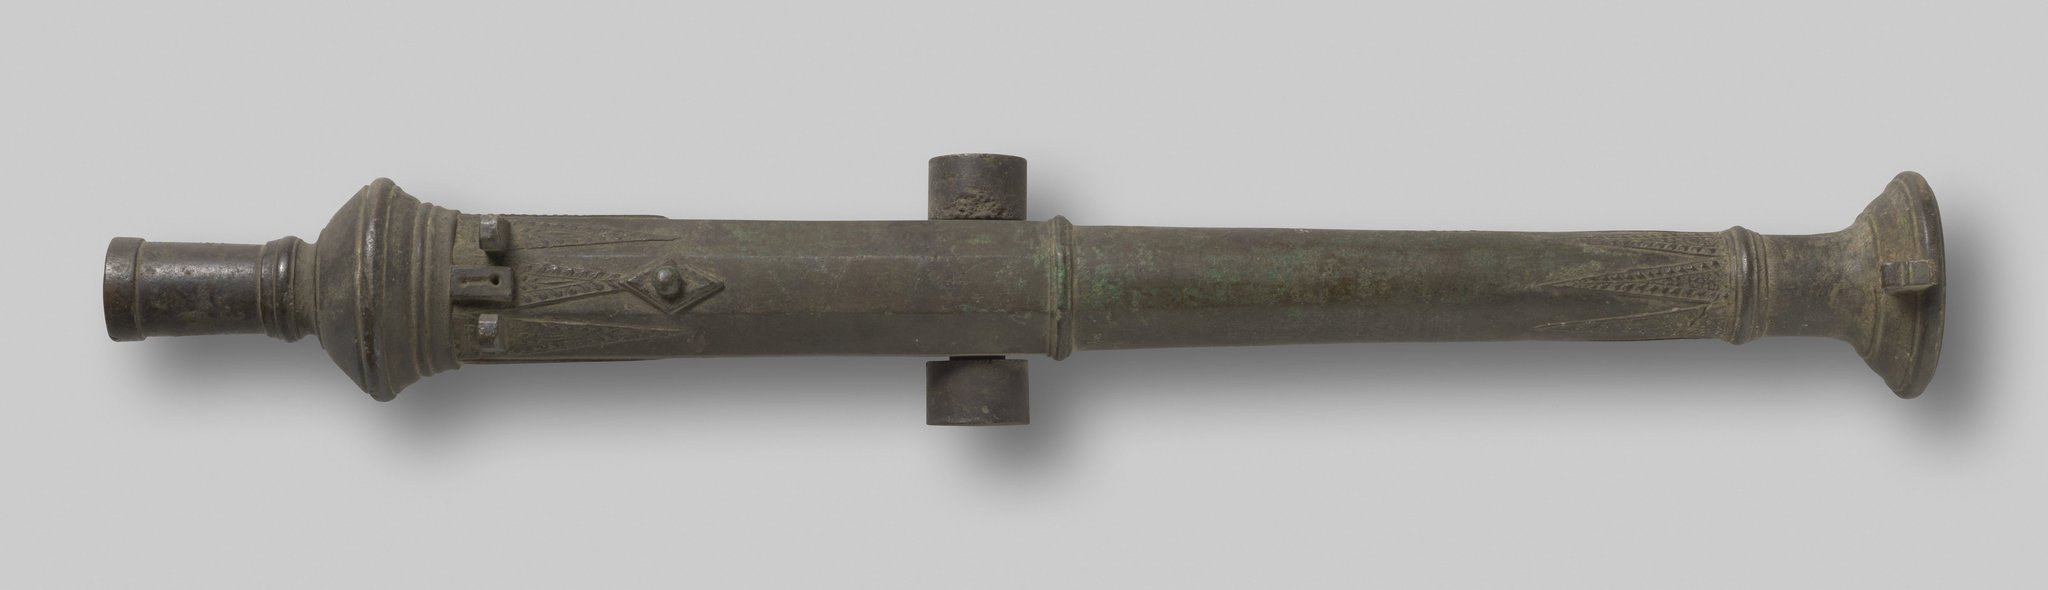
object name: lilla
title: Bronzen lilla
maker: Anonymous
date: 1896-1898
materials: bronze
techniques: casting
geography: nieuw-guinea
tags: nieuw-guinea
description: Bronzen lilla, versierd met driehoeken van bladornament aan monden en zundgaten, zonder oren. Afkomstig van de hoofden van Lahakia, Baik en Biroe (Zuidkust van Nieuw-Guinea) vormende gedeelte van de hun opgelegde boete wegens het in 1896 vermoorden van enige opvarenden van de Engelse kotter Lizzie.